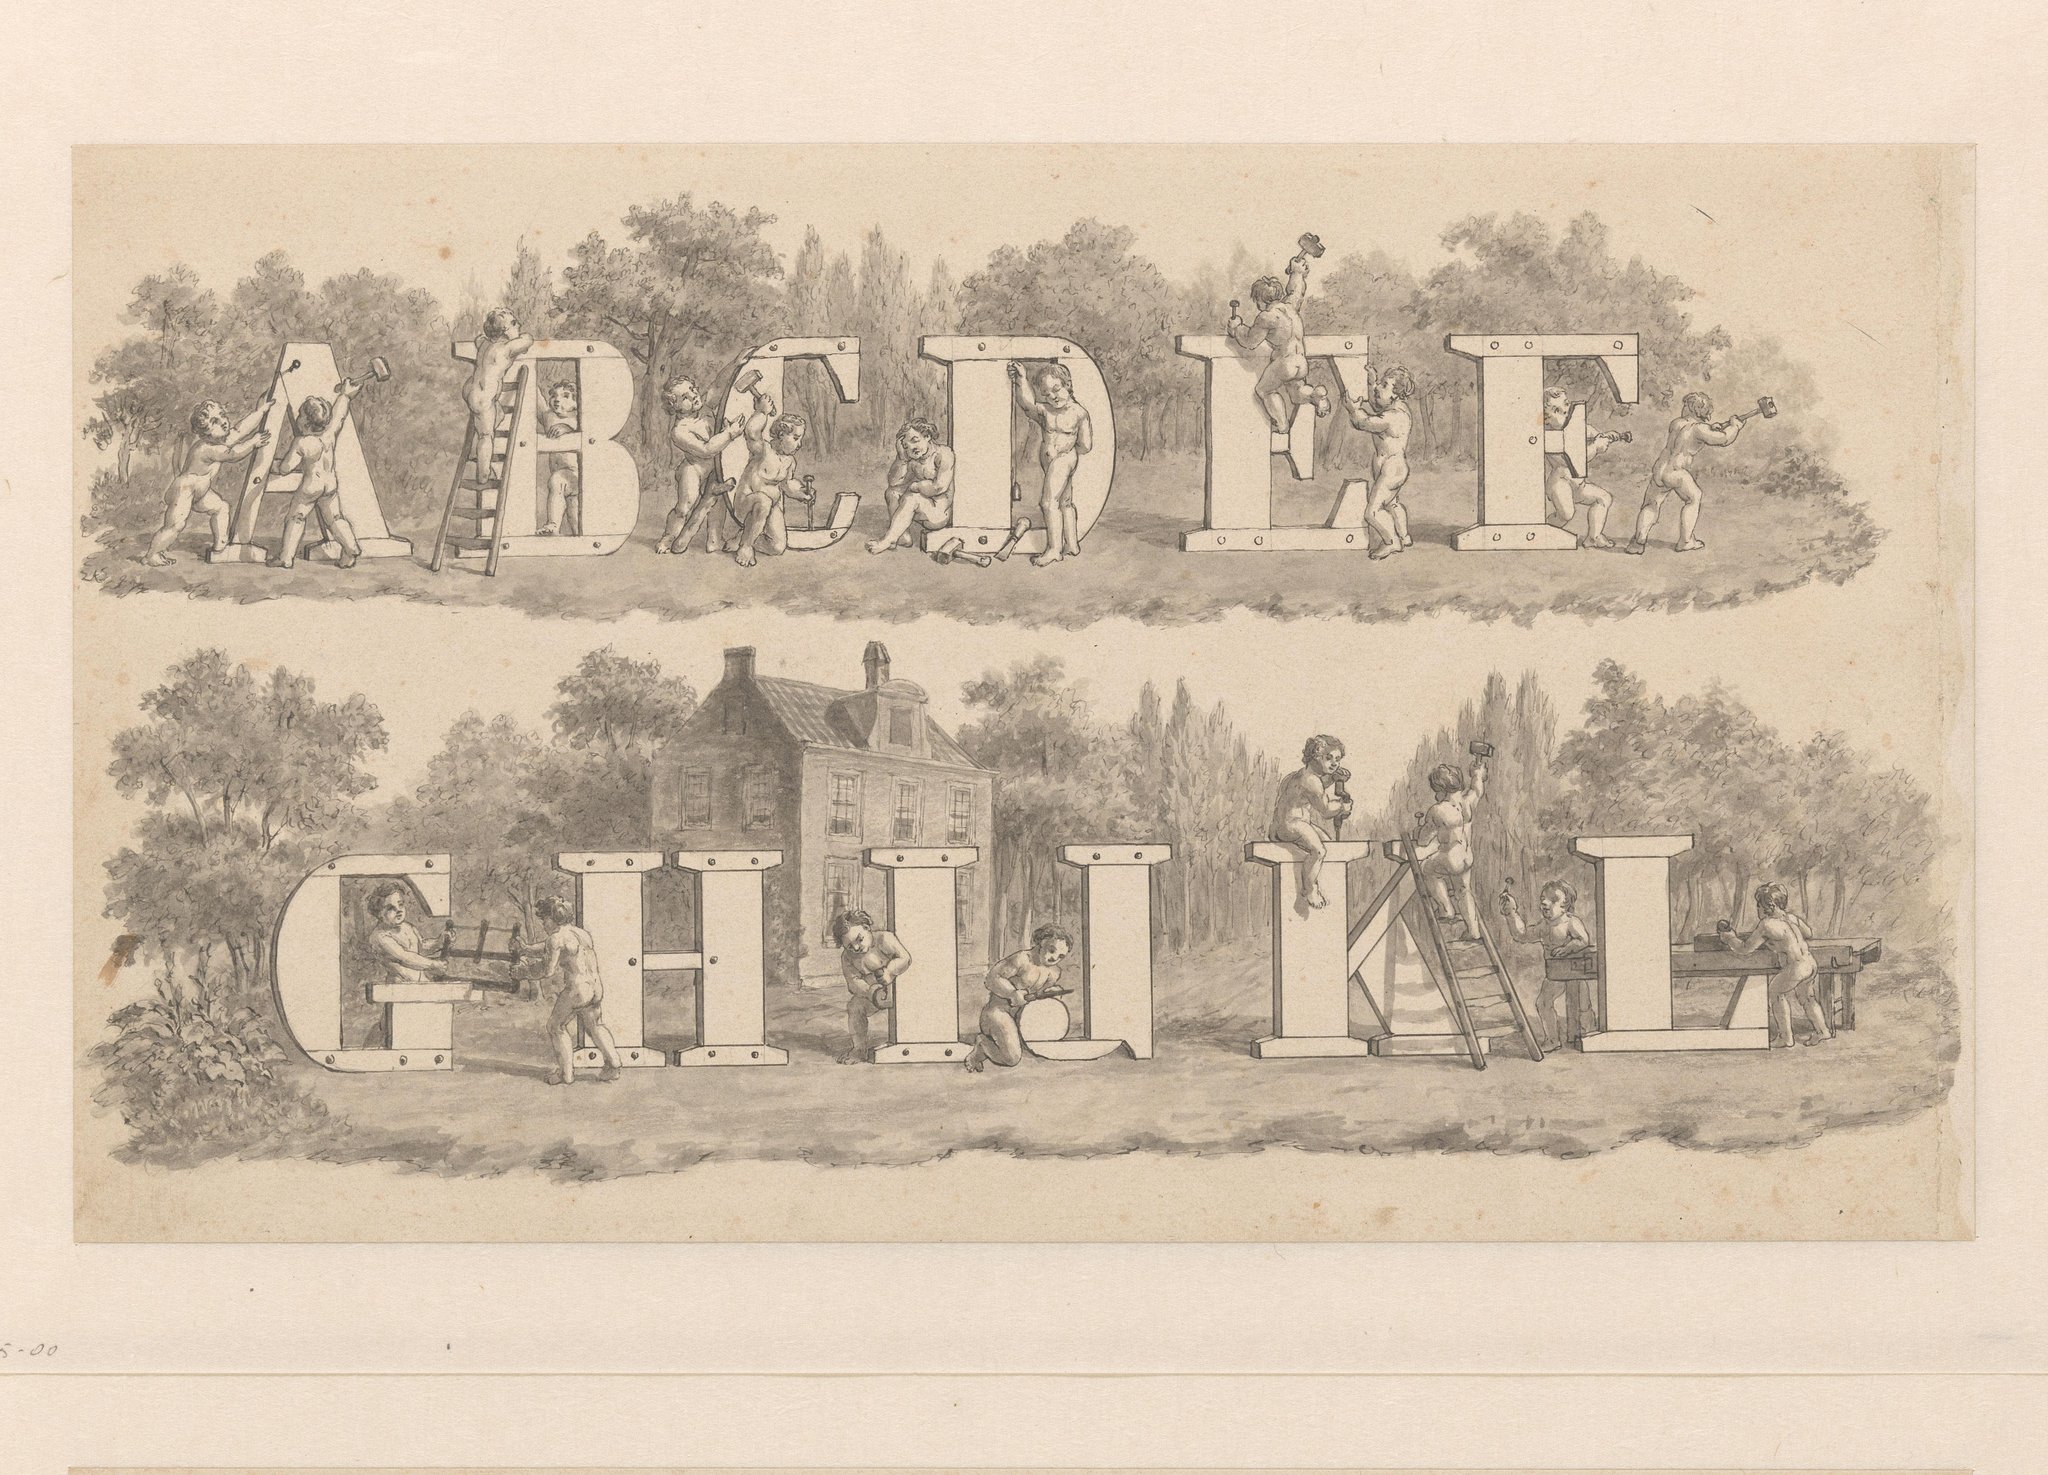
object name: design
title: Ontwerp voor illustratie voor In Holland staat een huis: silhouet van de familie en de knecht die vertrekt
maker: nelly bodenheim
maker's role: designer, draughtsman, print maker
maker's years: 1874-1951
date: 1884-1917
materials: paint, paper, pencil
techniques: brush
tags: 83(van looy, in holland staat een huis)